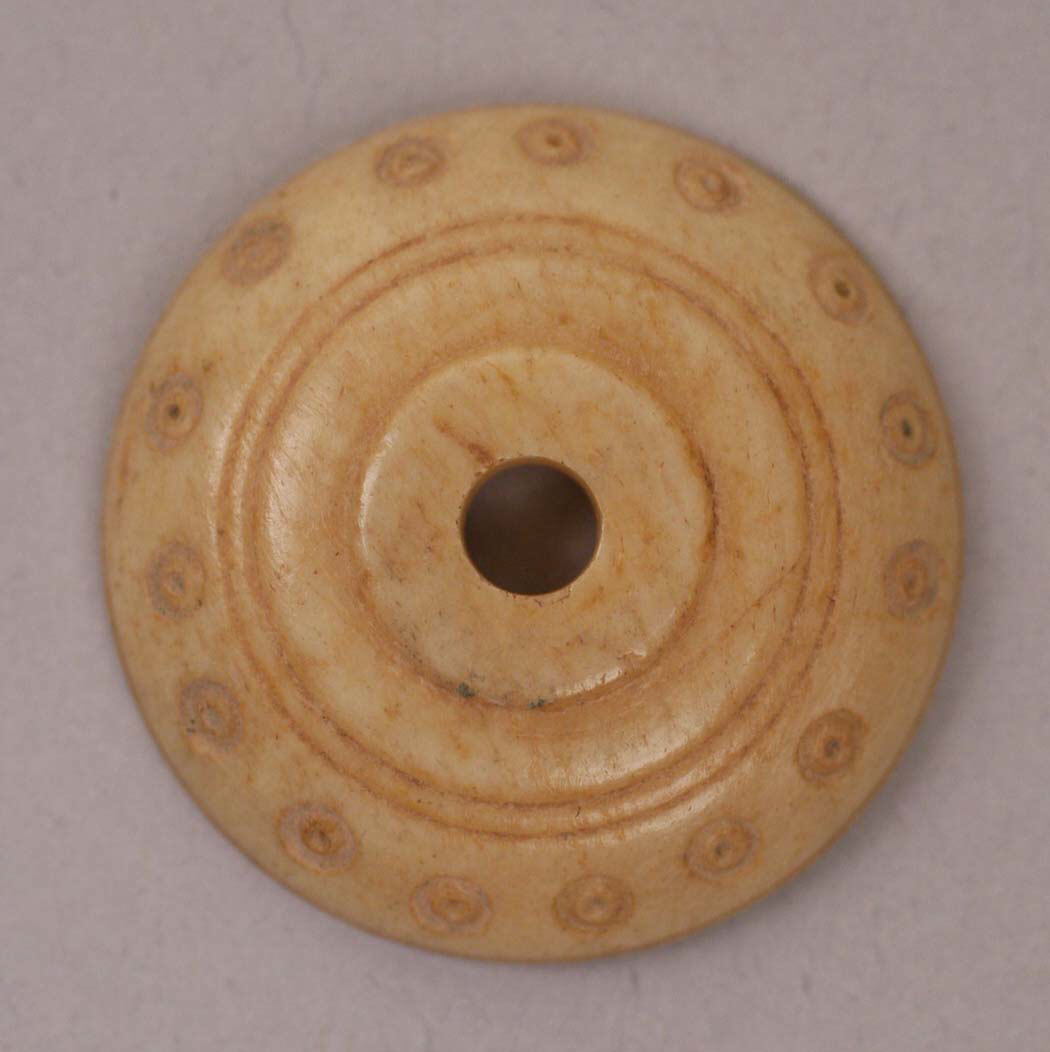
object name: button or bead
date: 801-1000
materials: bone, paint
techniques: incising, inlay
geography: iran